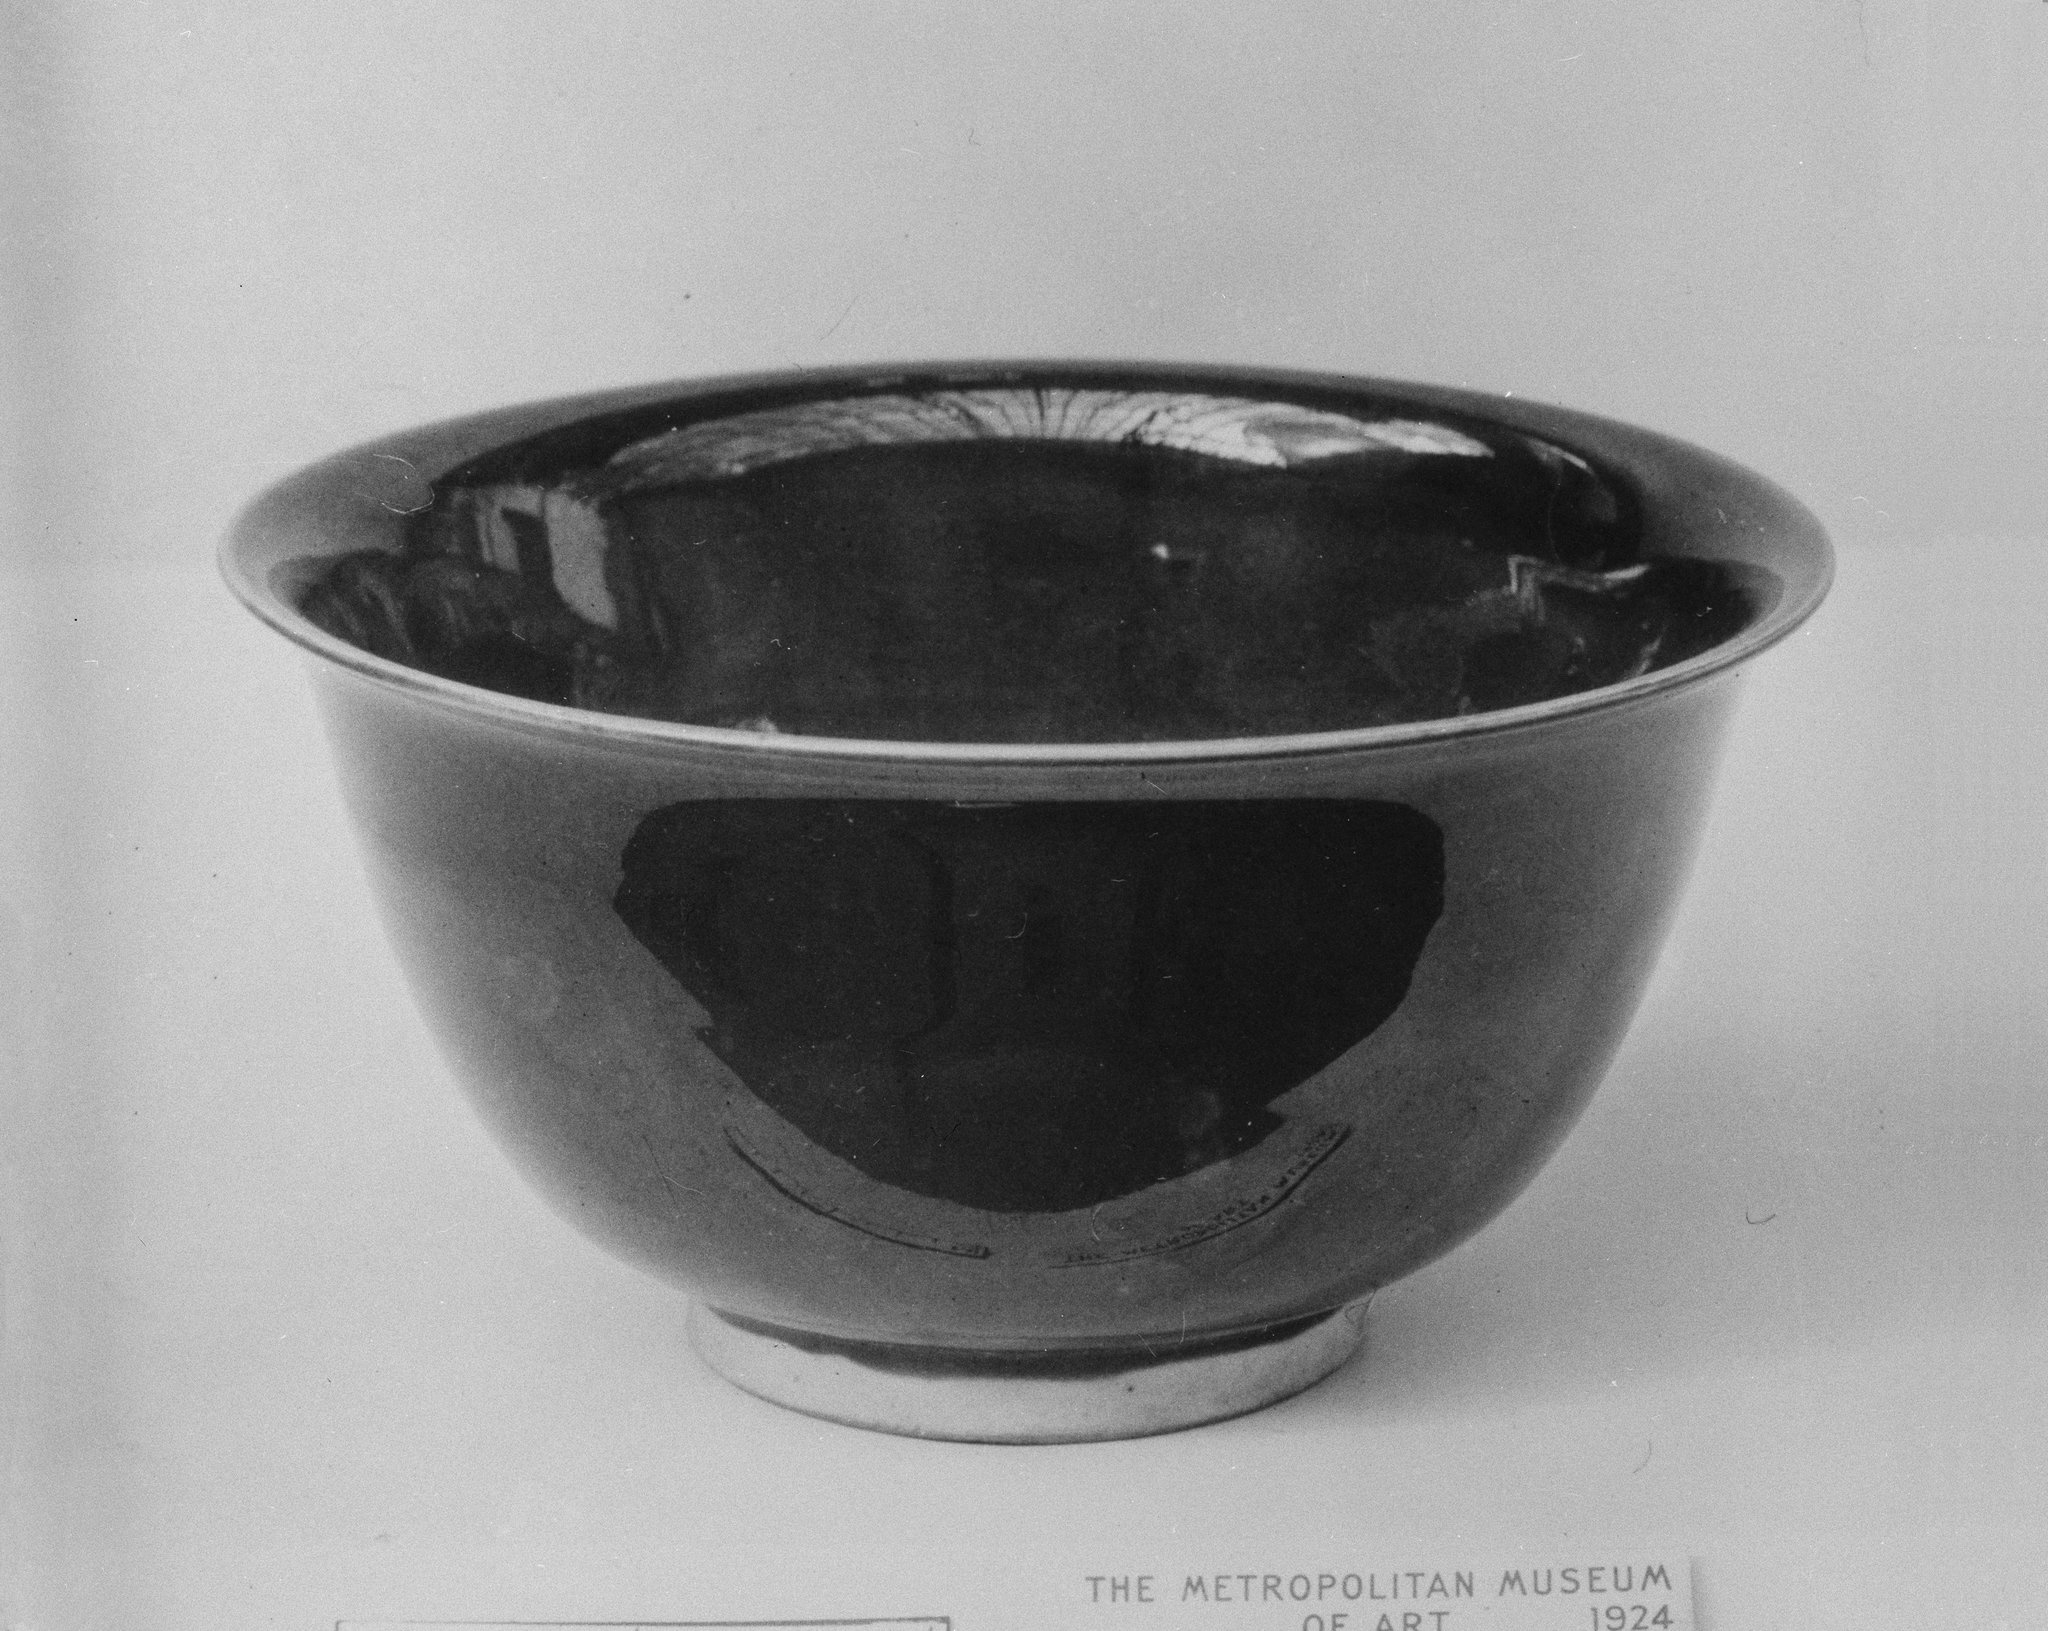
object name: bowl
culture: japanese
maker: eiraku hozen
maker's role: artist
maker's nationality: japanese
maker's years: 1795-1854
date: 1830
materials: faience, glaze